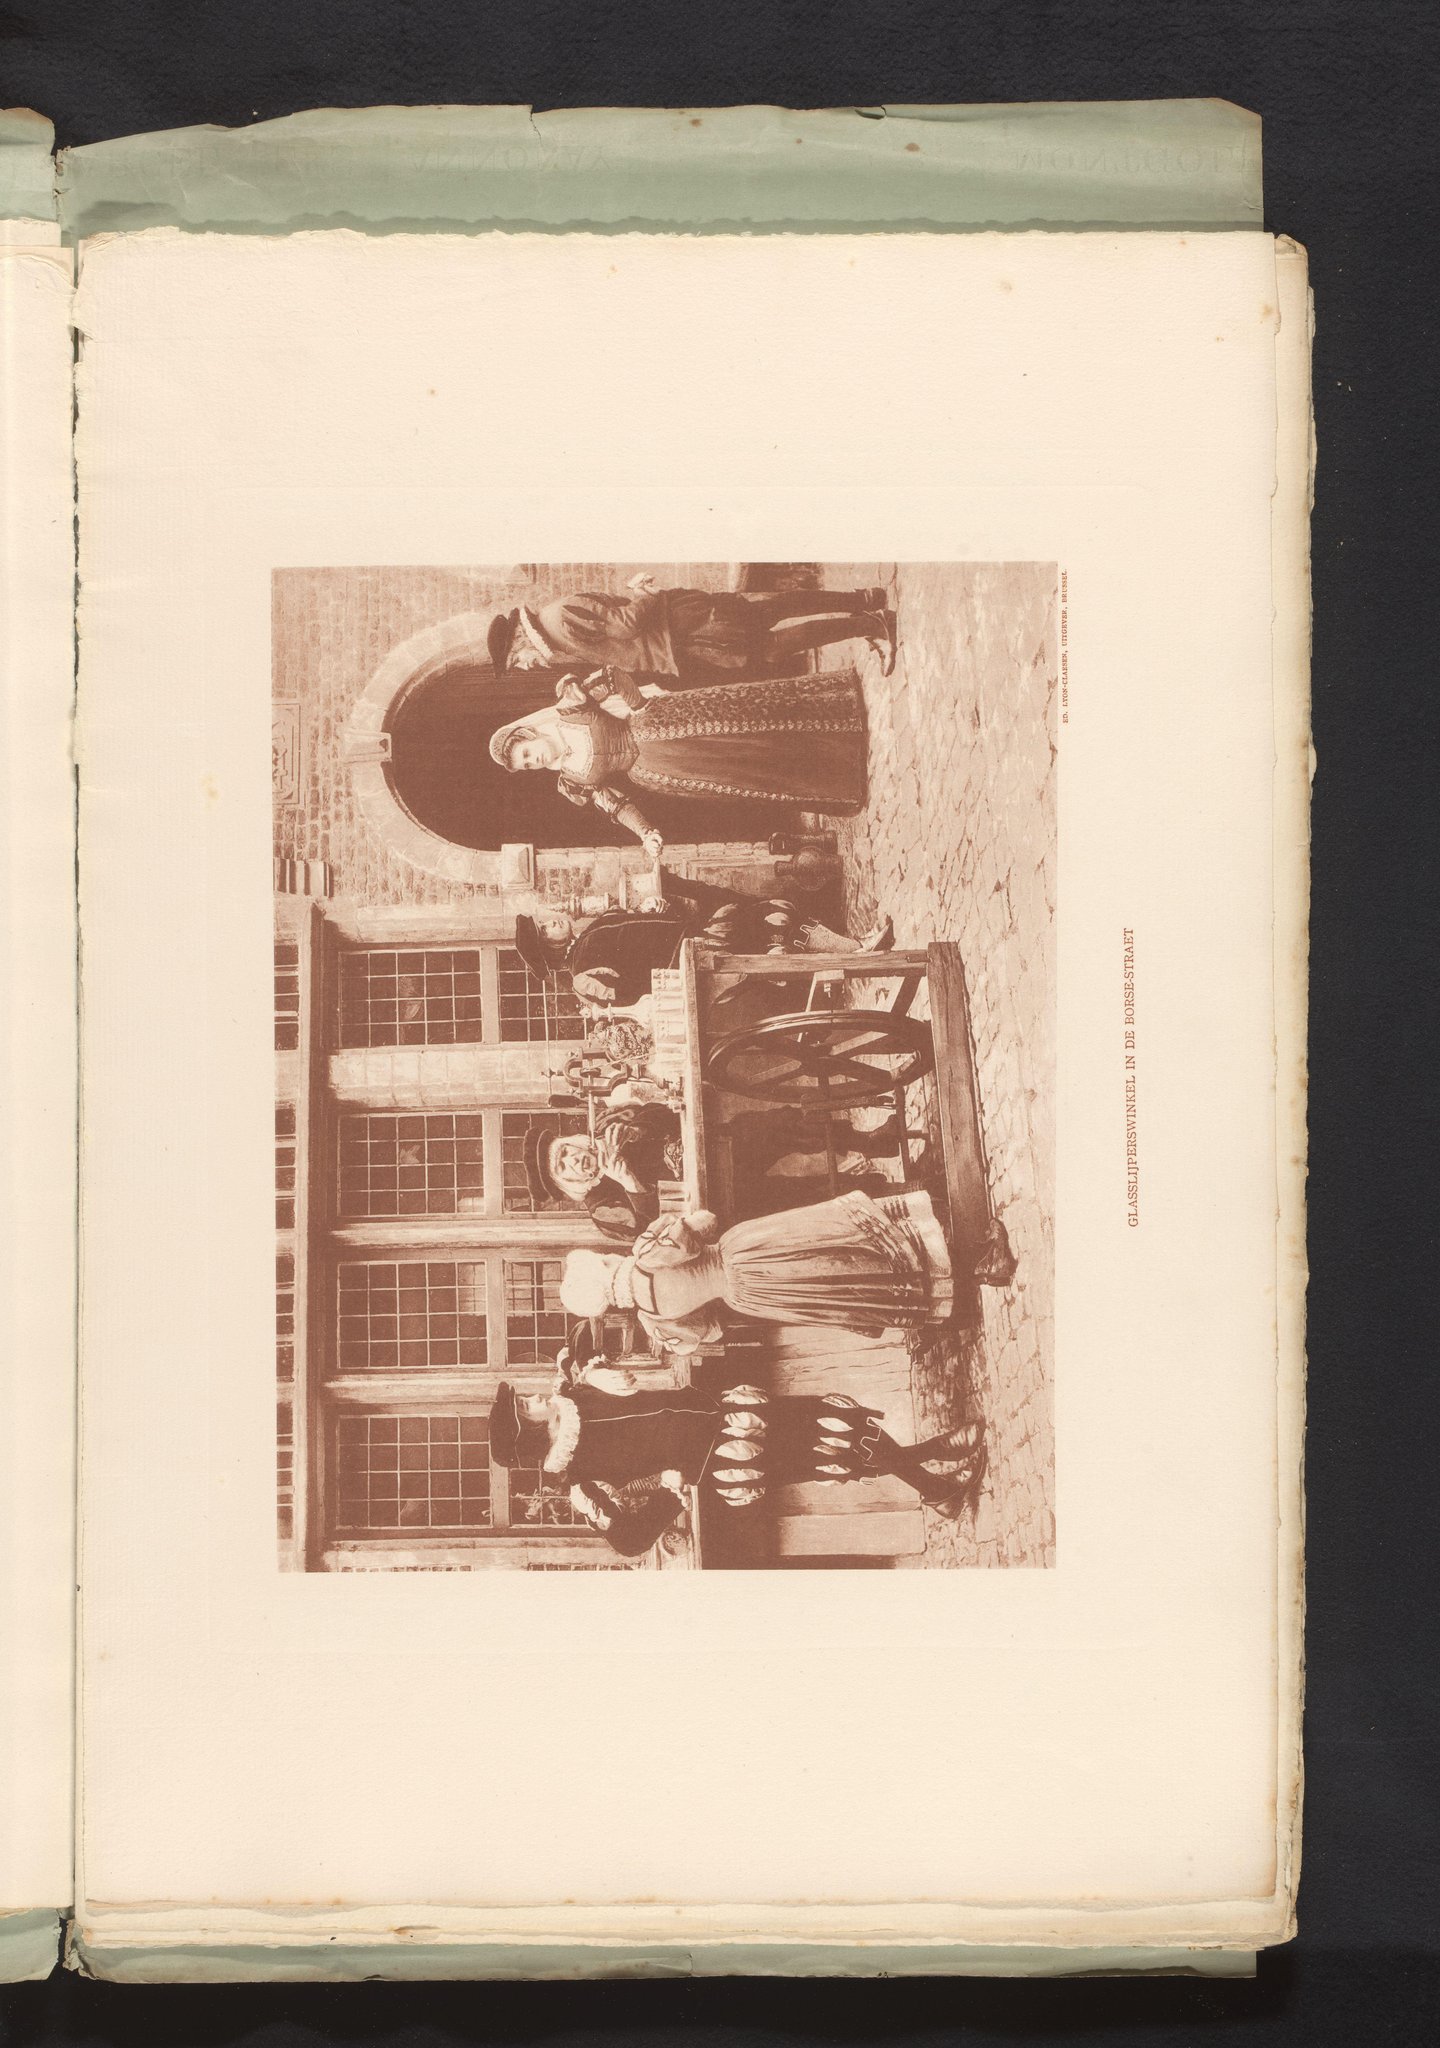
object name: page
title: Glasslijperswinkel in de Borse-straet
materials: paper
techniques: photograph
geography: antwerp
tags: glass-maker, world fair, world exhibition, antwerp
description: Prent op los blad tussen pagina 44 en 45.